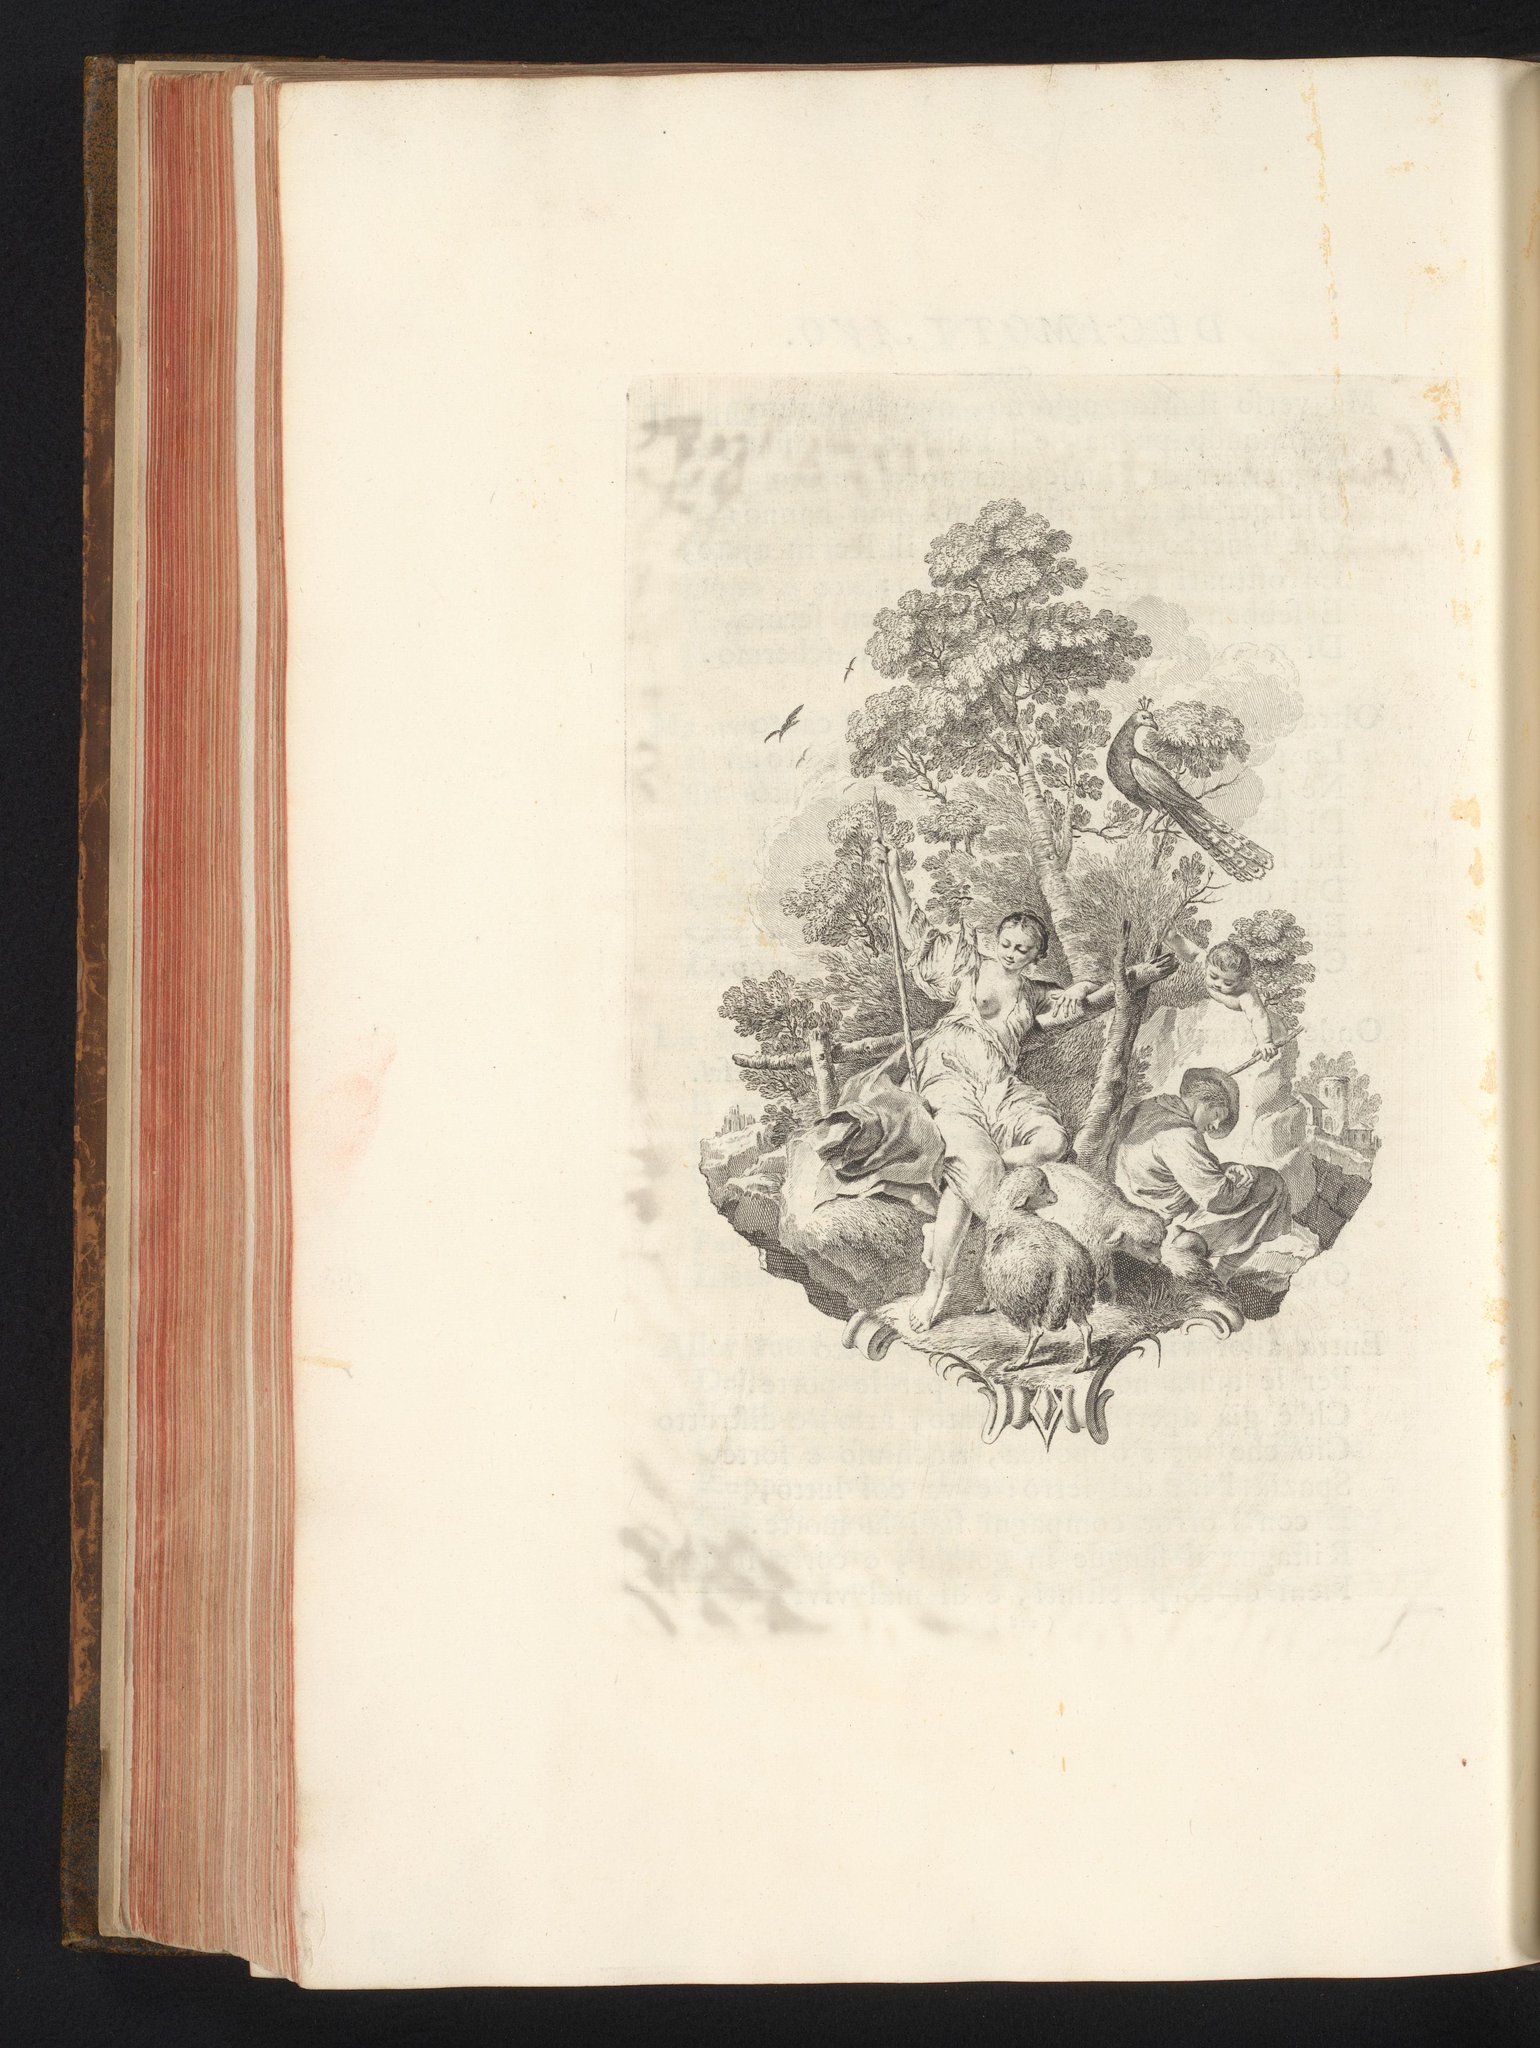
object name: book illustration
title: Pastorale scène met herders en pauw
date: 1745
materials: paper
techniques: etching, letterpress printing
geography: venice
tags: herding, herdsman, herdswoman, shepherd, shepherdess, cowherd, etc., ornamental birds: peacock, (scenes from) specific works of literature: tasso, gerusalemme liberata, pastorals, arcadian scenes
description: Prent uit: Tasso, Torquato. La Gerusalemme liberata di Torquato Tasso con le figure de Giambatista Piazzetta. Venetië: Giambatista Albrizzi, 1745.